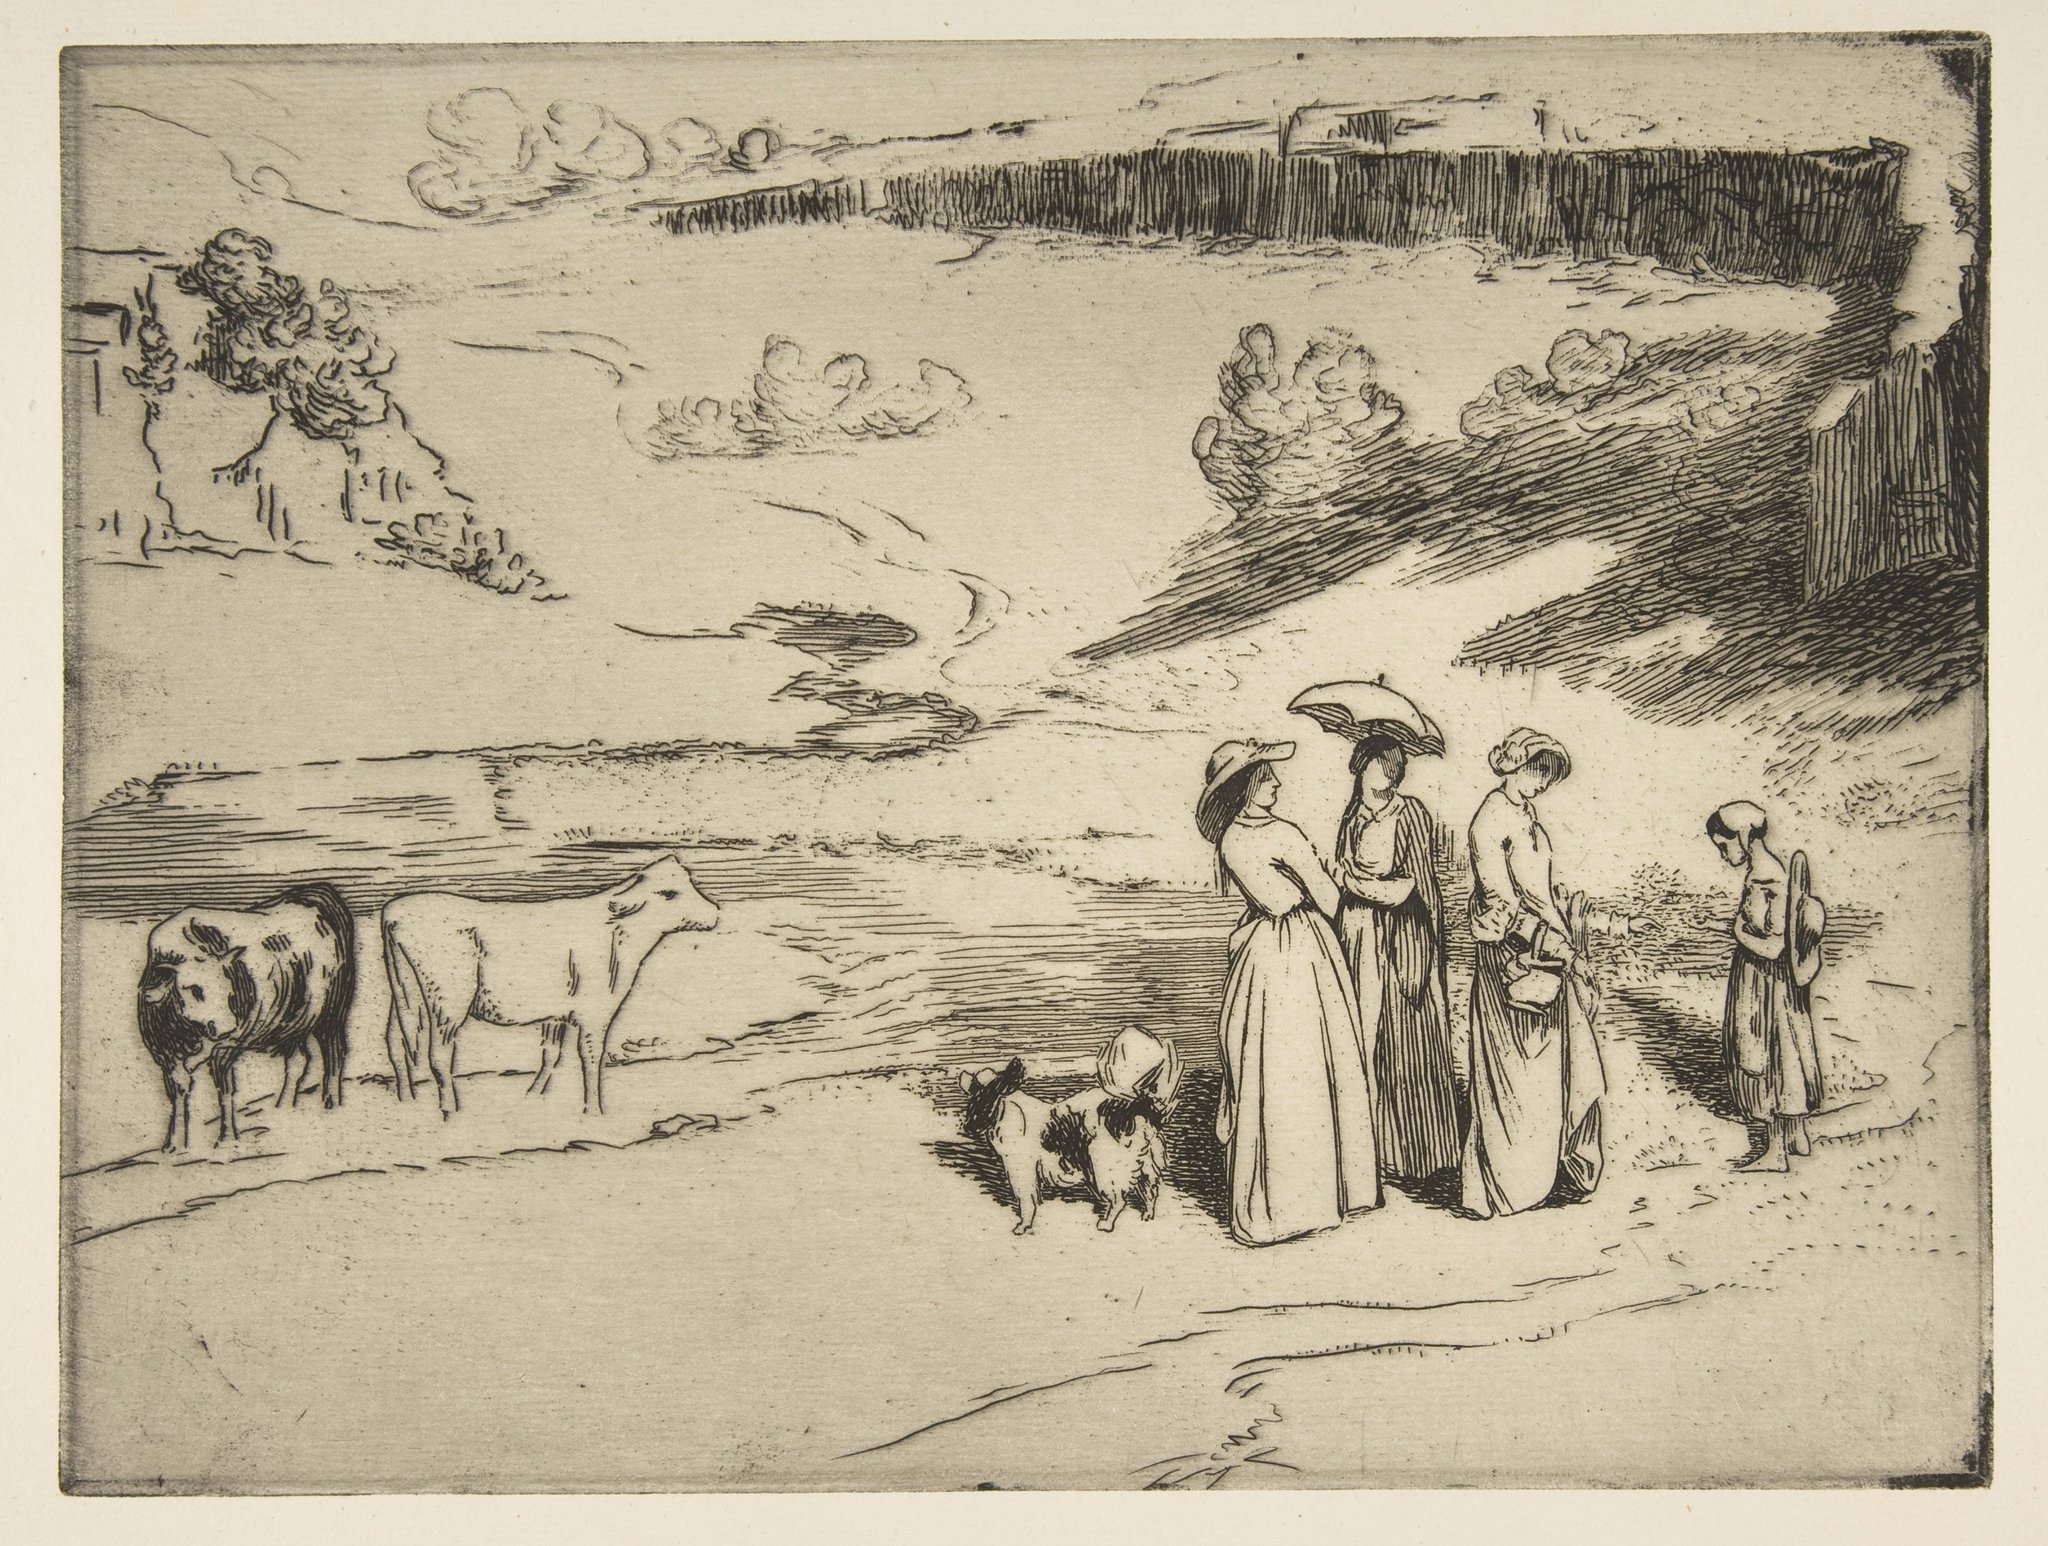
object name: print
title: Les Demoiselles du village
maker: félix bracquemond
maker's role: artist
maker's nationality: french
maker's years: 1833-1914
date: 1869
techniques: etching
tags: villages,women,cows